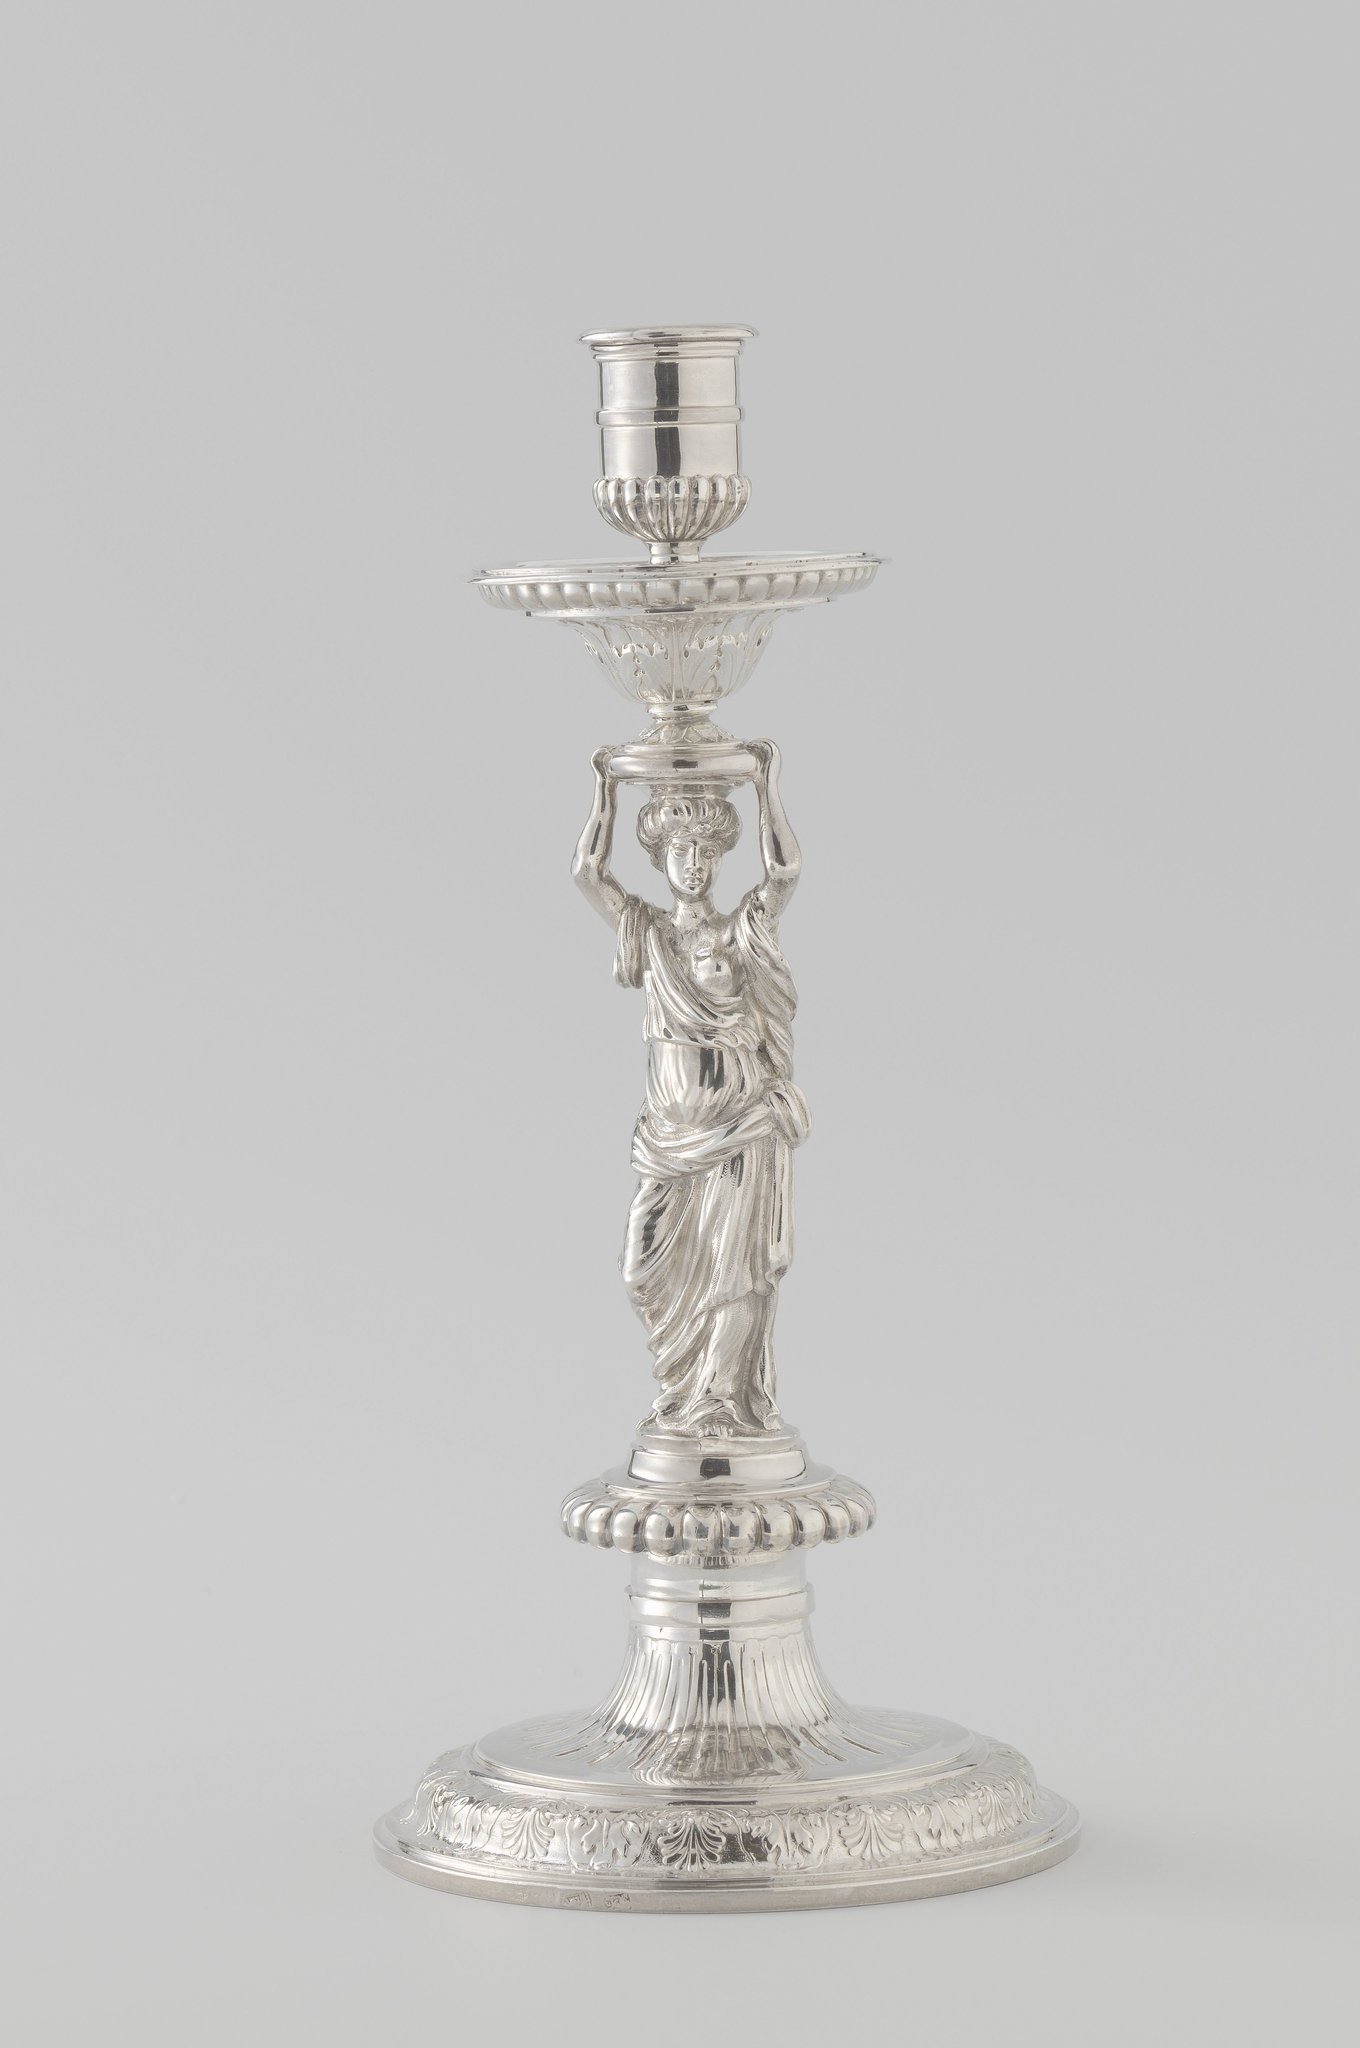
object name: candlestick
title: Two candlesticks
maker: adam loofs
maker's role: goldsmith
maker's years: 1645-1710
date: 1687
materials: silver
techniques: casting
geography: the hague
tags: standing figure - aa - female human figure, carrying something on the head or on the shoulders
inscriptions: alloy mark, maker's mark, inscription: ‘W’, date letter: ‘N’, town mark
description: Adam Loofs was silversmith and silver steward to Stadtholder William III. After having worked for King Louis XIV in Paris, he moved to The Hague in 1680. These candlesticks may have been made for William III. They are based directly on the silver furnishings and other objects at Versailles.